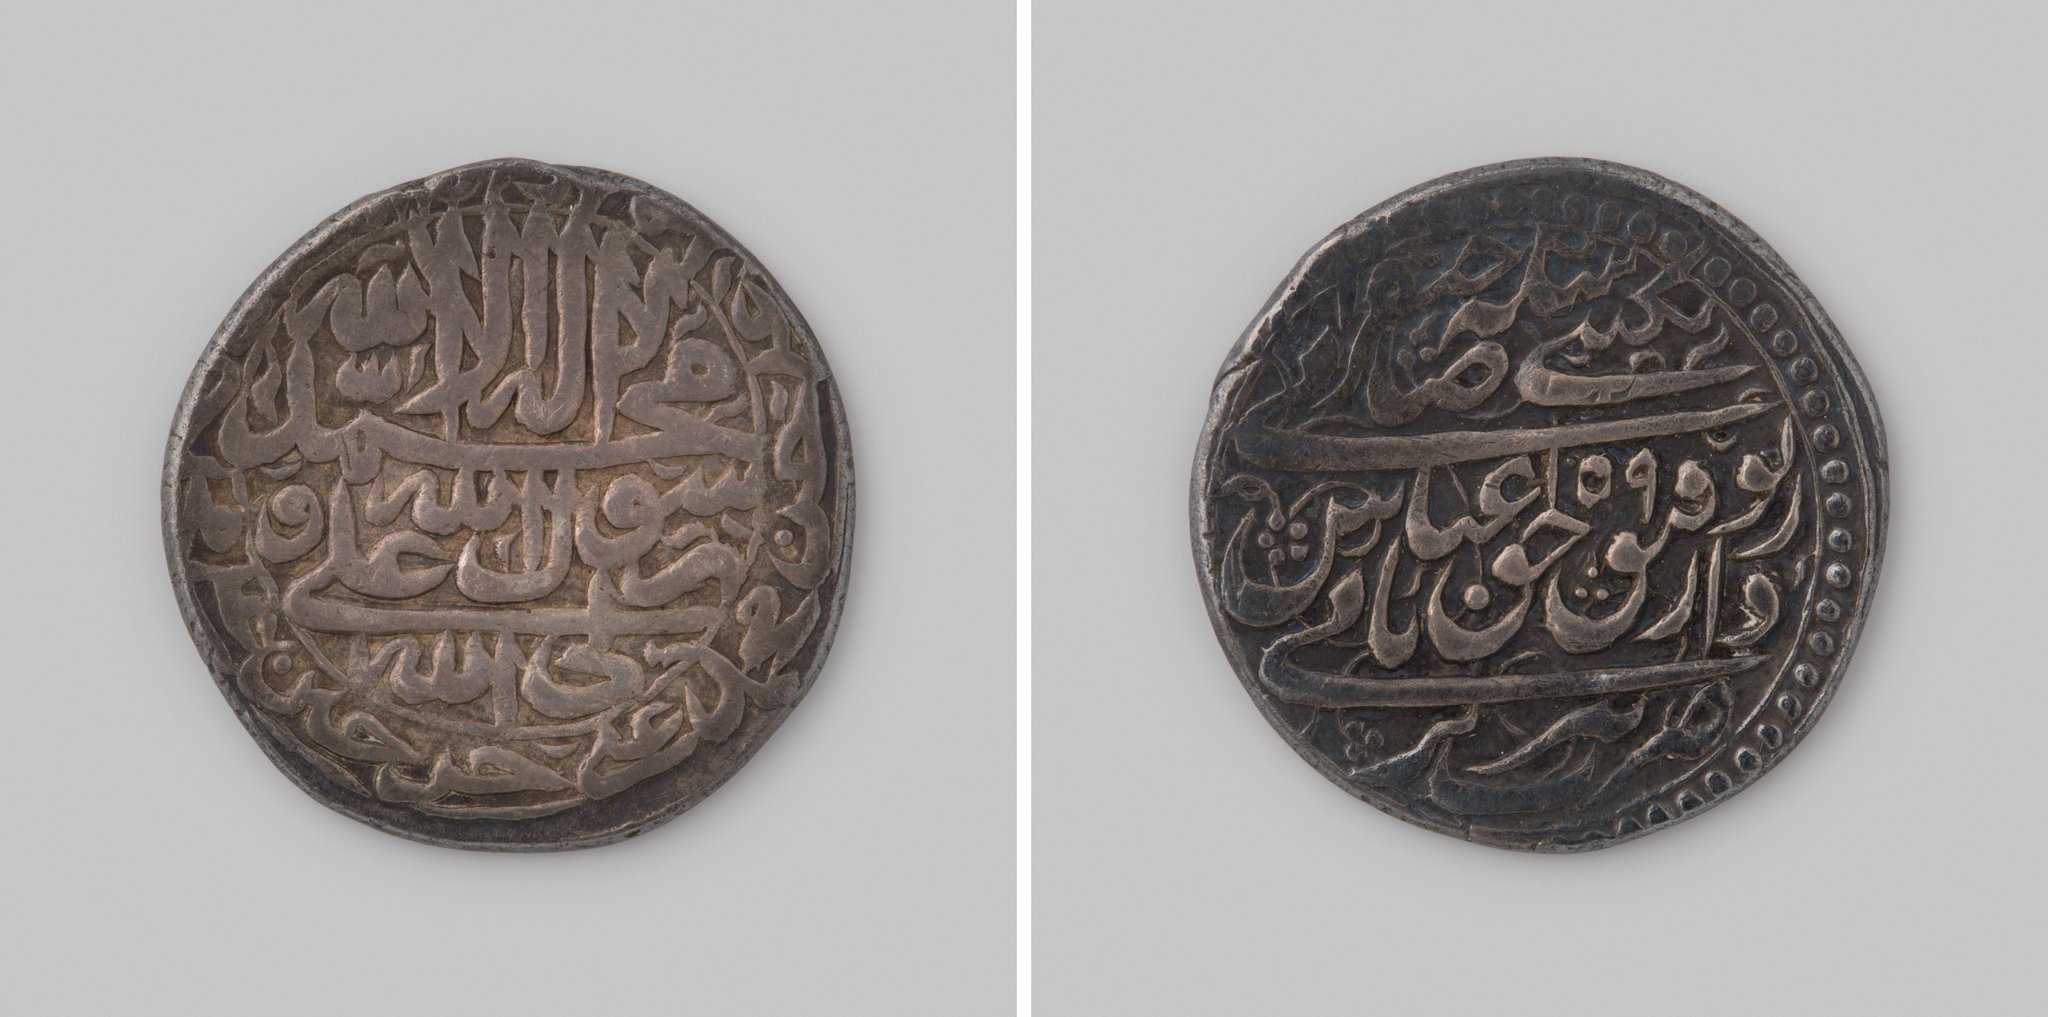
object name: coin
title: Abbasi uit Perzië van sjah Abbas II, 1052-1077 AH [=1642-1666], 1059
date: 1649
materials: silver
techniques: striking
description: Zilveren munt. Voorzijde: binnen cirkel in Arabische lettertekens Shiitische kalima [=geloofsbelijdenis] in drie regels.Rondom cirkel in Arabische lettertekens omschrift. Keerzijde: in Arabische lettertekens in twee regels rijmdicht. Jaartal: 59 boven tweede regel. Daaronder muntplaats-aanduiding: Tabriz.